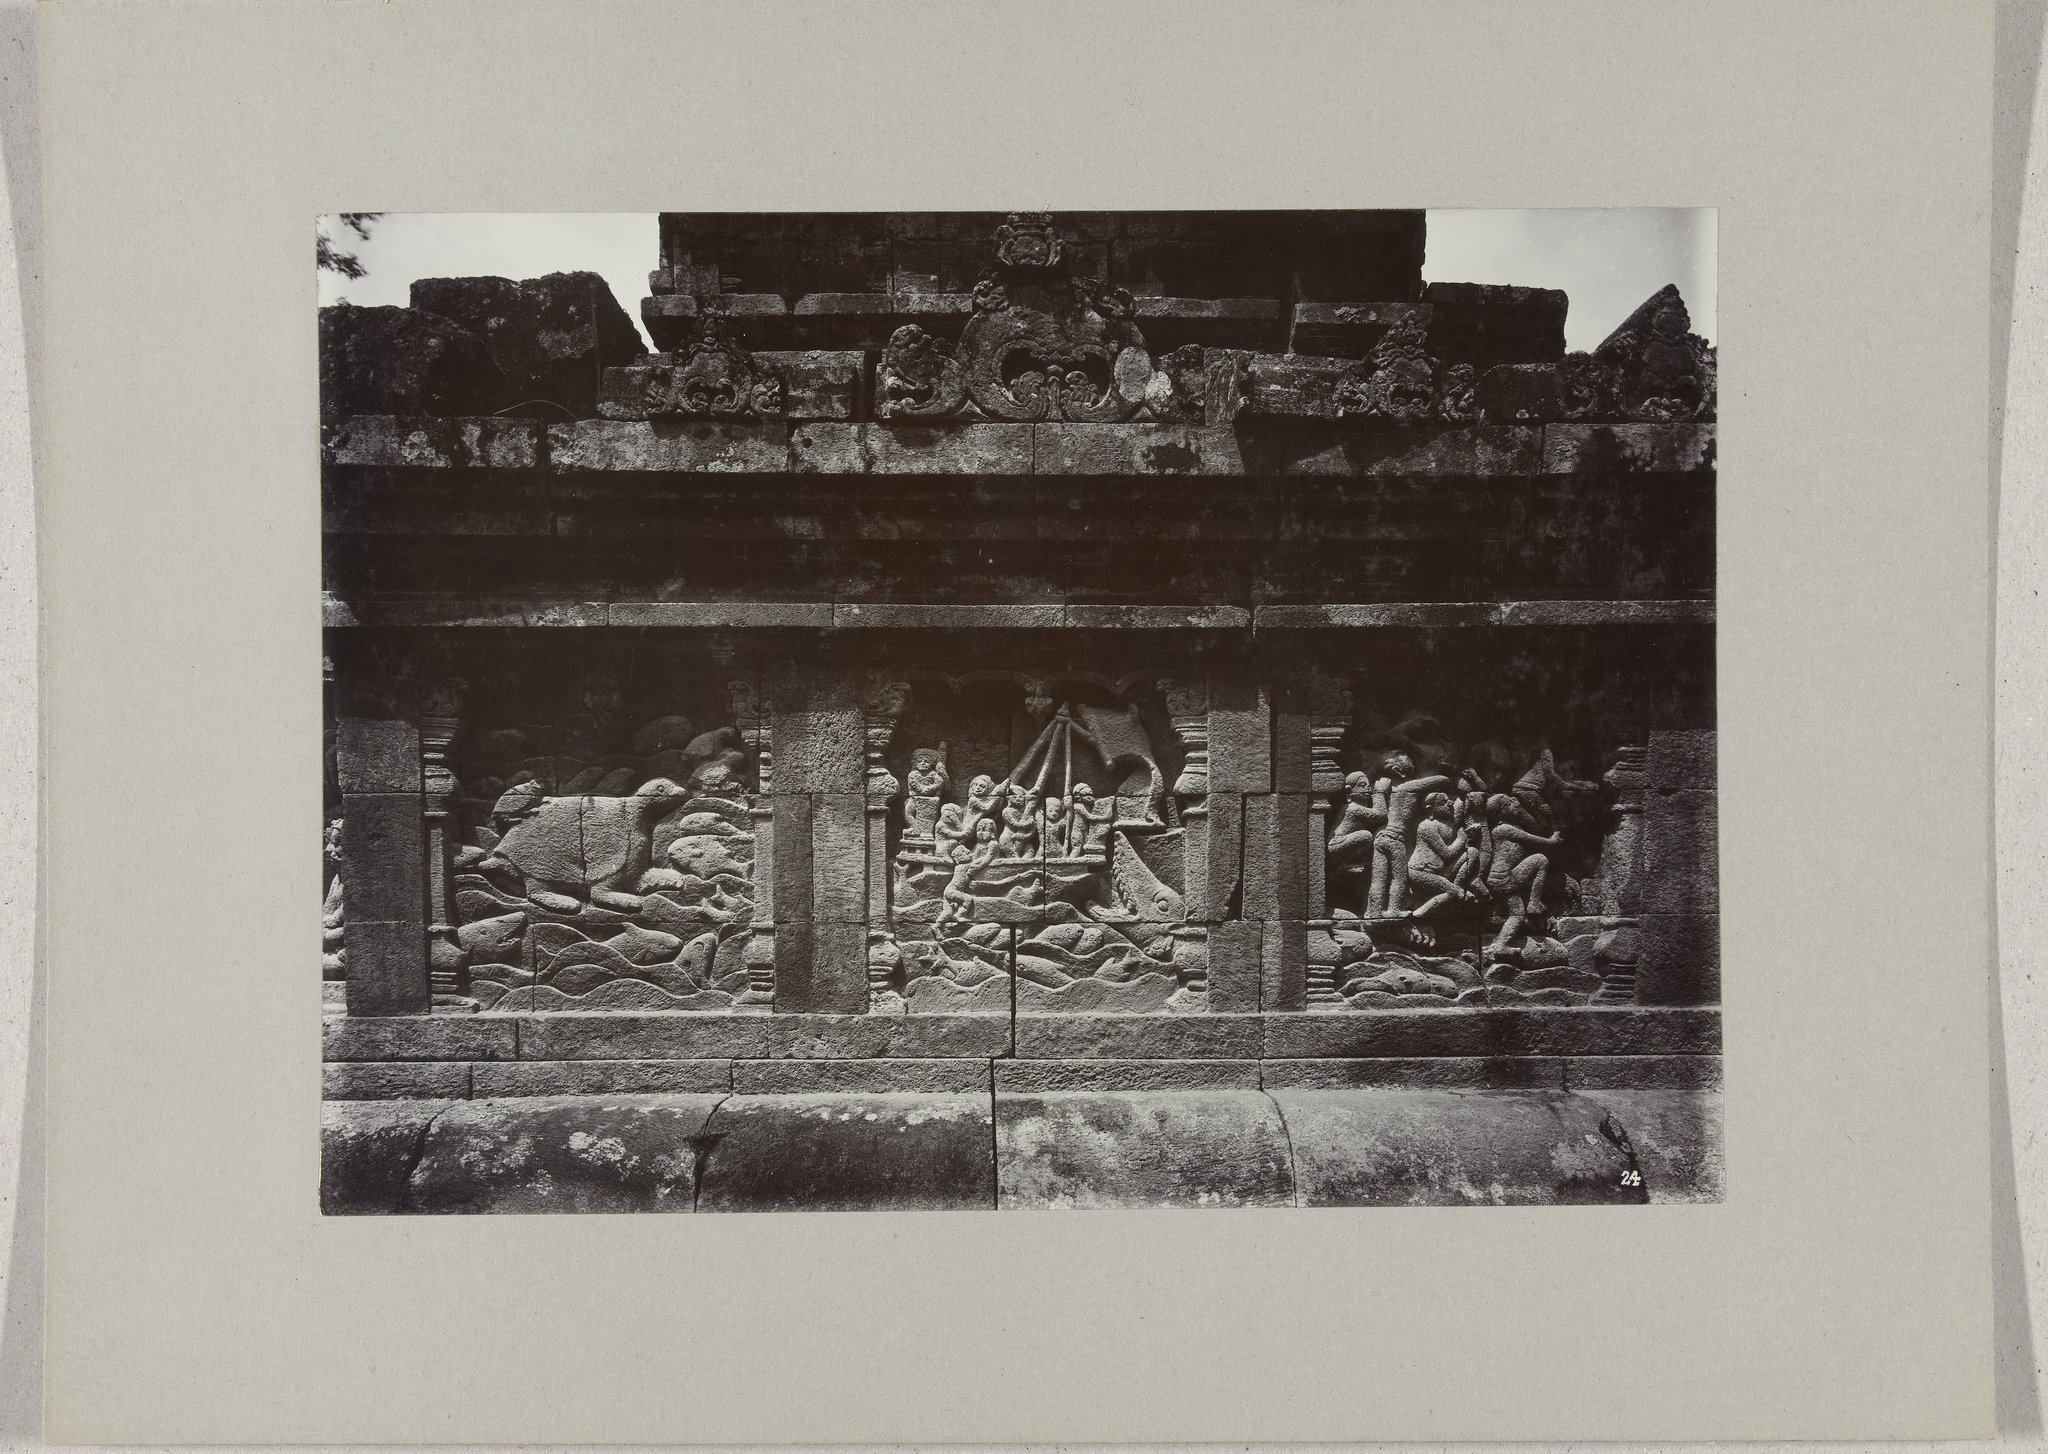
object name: photograph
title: Reliëf van de Borobudur (Boroboedoer), nabij Magelang, Nederlands-Indië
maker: onnes kurkdjian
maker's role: fotograaf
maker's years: 1851-1903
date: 1895-1915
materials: cardboard, paper, photographic support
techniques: gelatin silver print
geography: magelang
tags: borobudur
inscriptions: number: ‘24’, annotation: ‘81. Boroboedoer’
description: Reliëf van de Borobudur (Boroboedoer), nabij Magelang, Nederlands-Indië